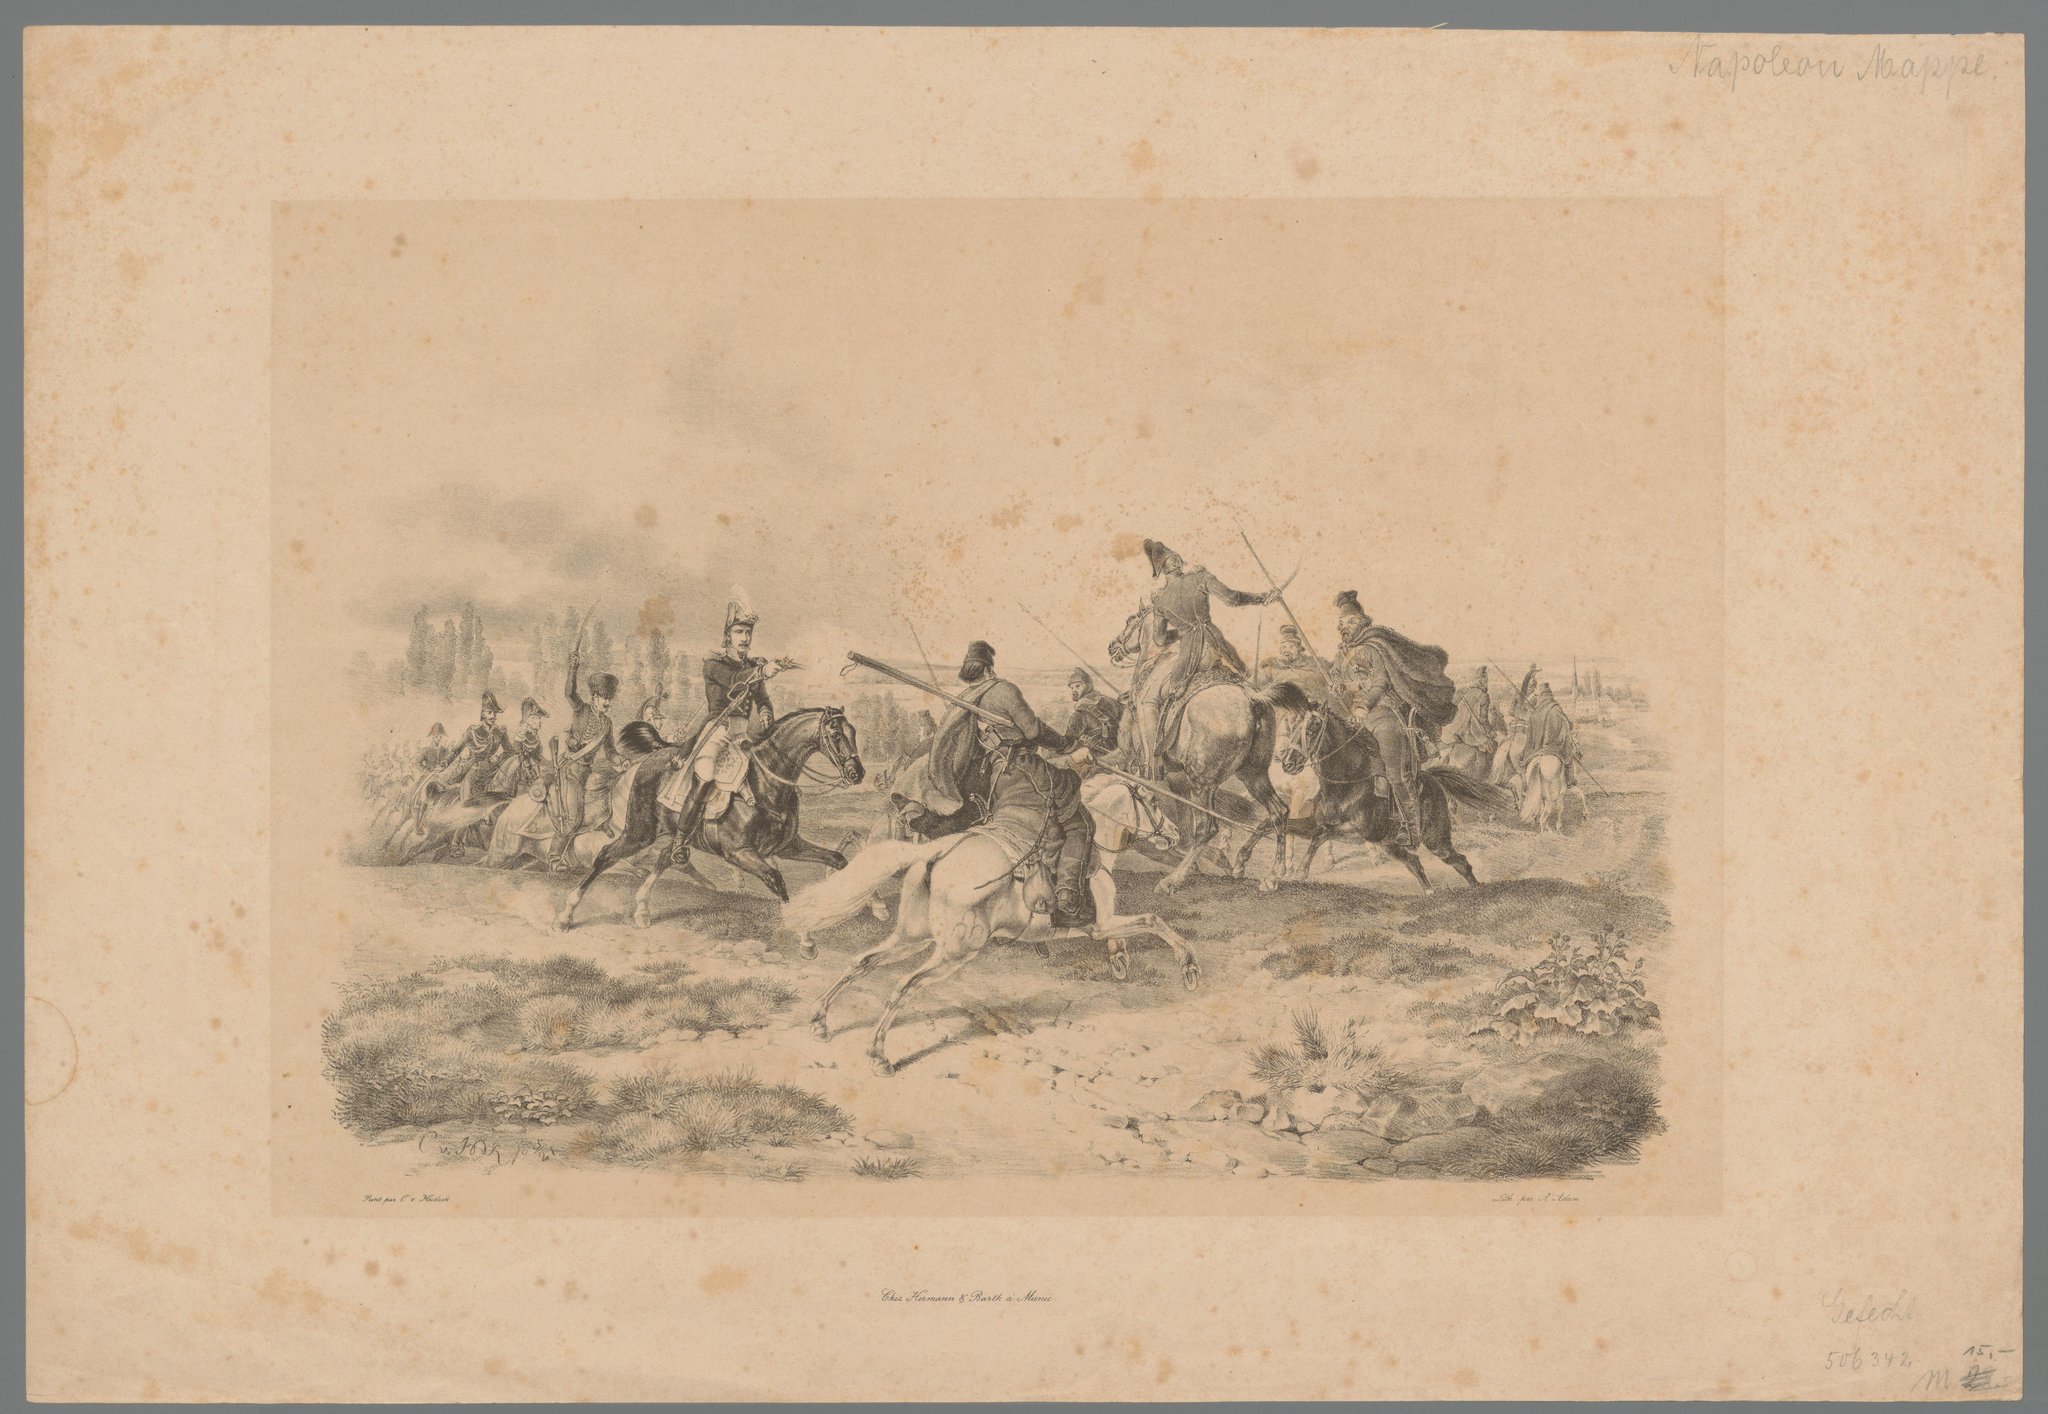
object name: print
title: Voyage pittoresque et militaire de Willenberg en Prusse jusqu’à Moscou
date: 1827-1833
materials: paper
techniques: tone lithography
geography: munich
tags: battle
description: Veldslag met cavalerie tijdens Napoleons veldtocht naar Rusland.